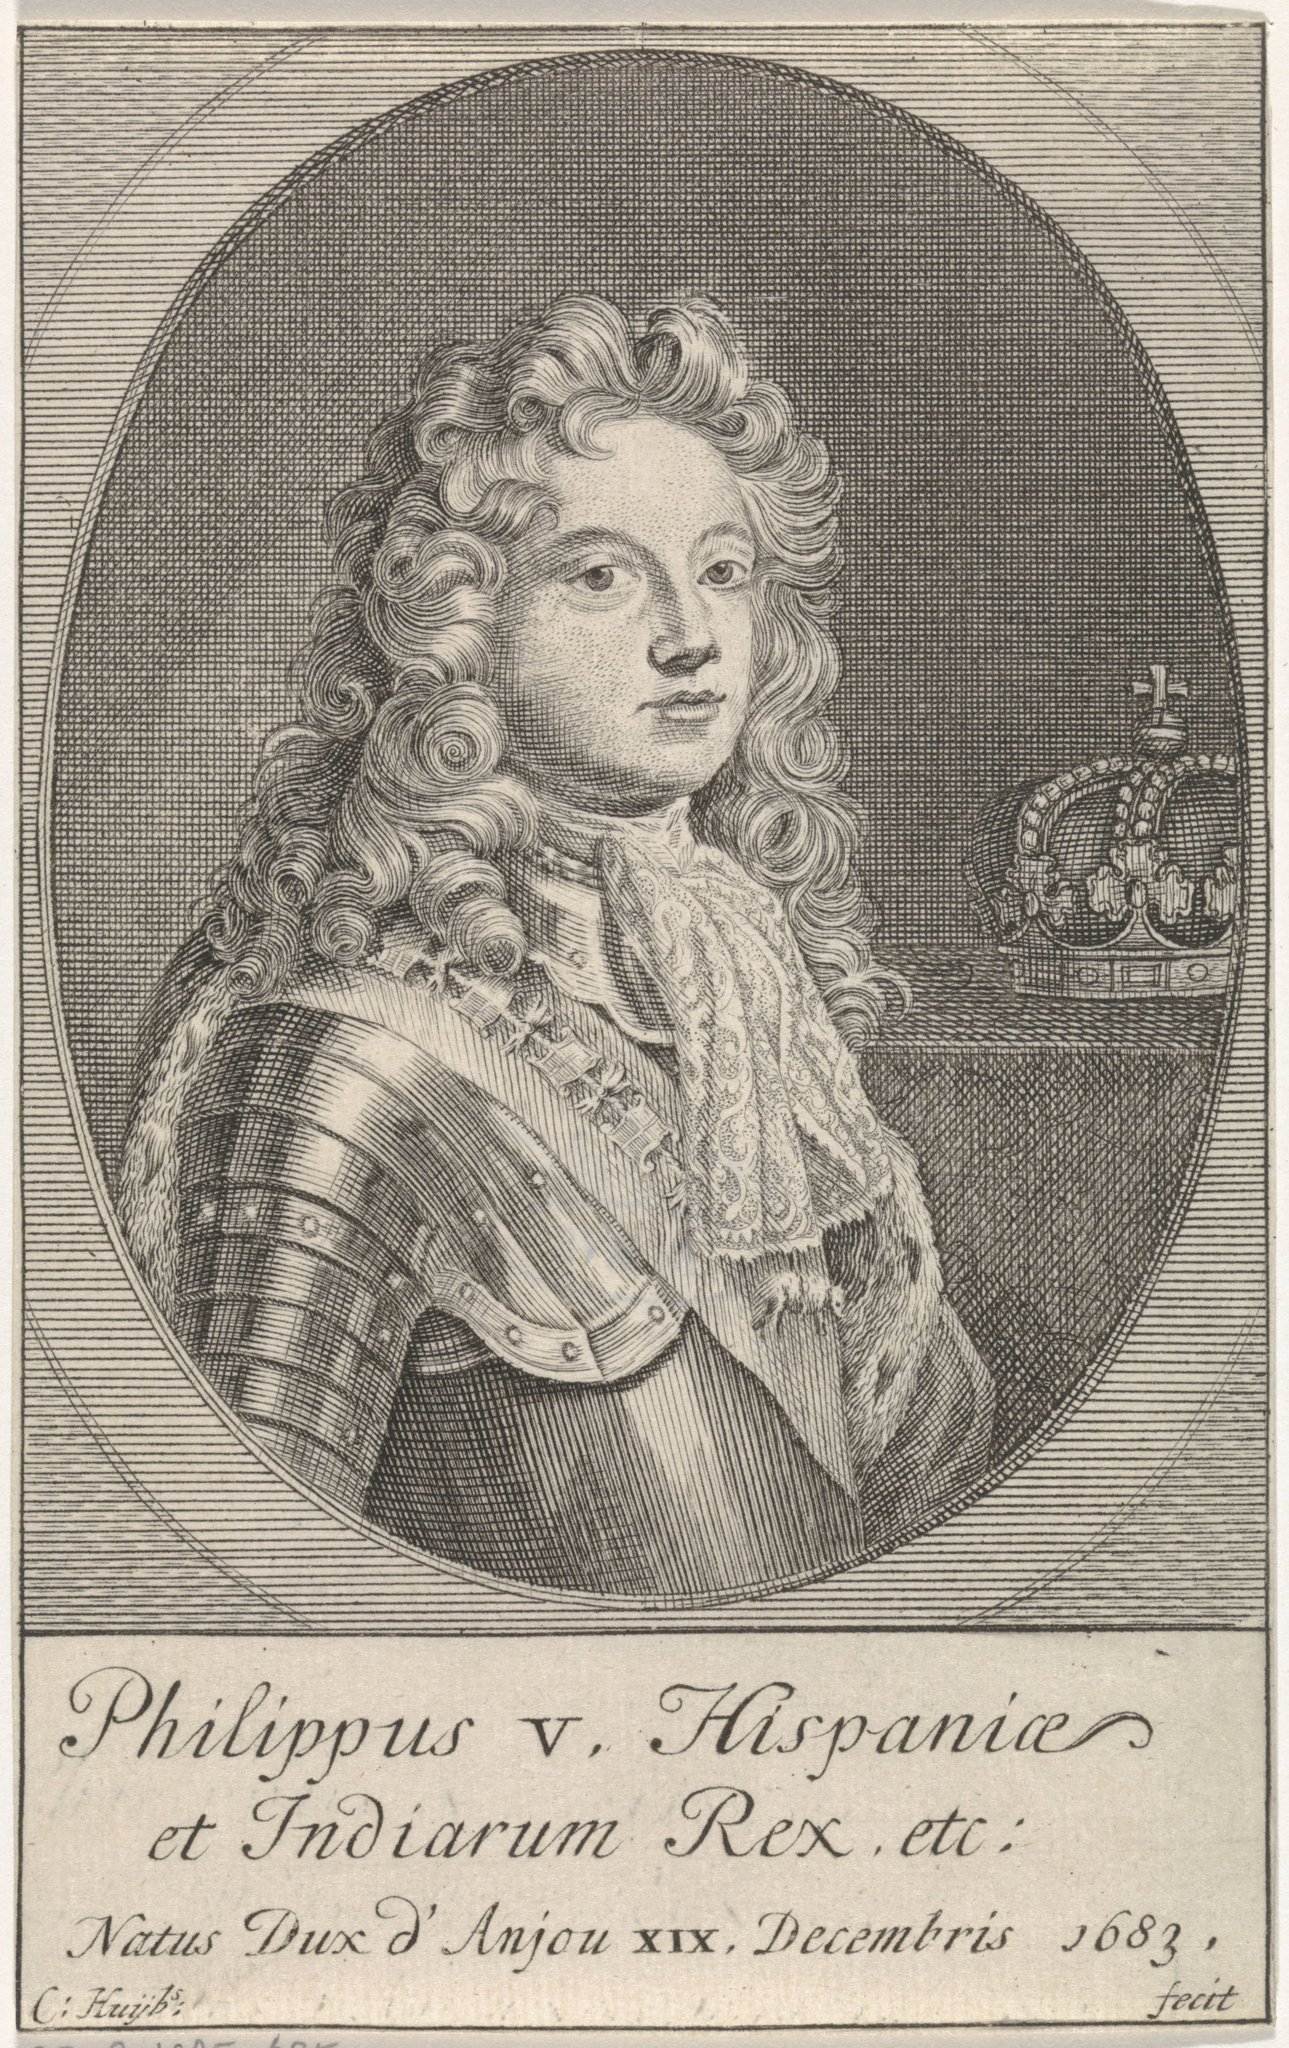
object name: print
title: Portret van Filips V, koning van Spanje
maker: cornelis huyberts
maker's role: print maker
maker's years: 1669-1709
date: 1700-1712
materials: paper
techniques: engraving, etching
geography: amsterdam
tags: filips v (koning van spanje)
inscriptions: collector's mark: Lugt 2228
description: Filips V, gekleed in harnas, rechts van hem een kroon. Buste naar rechts in een ovaal. Onder een drieregelige tekst in het Latijn.